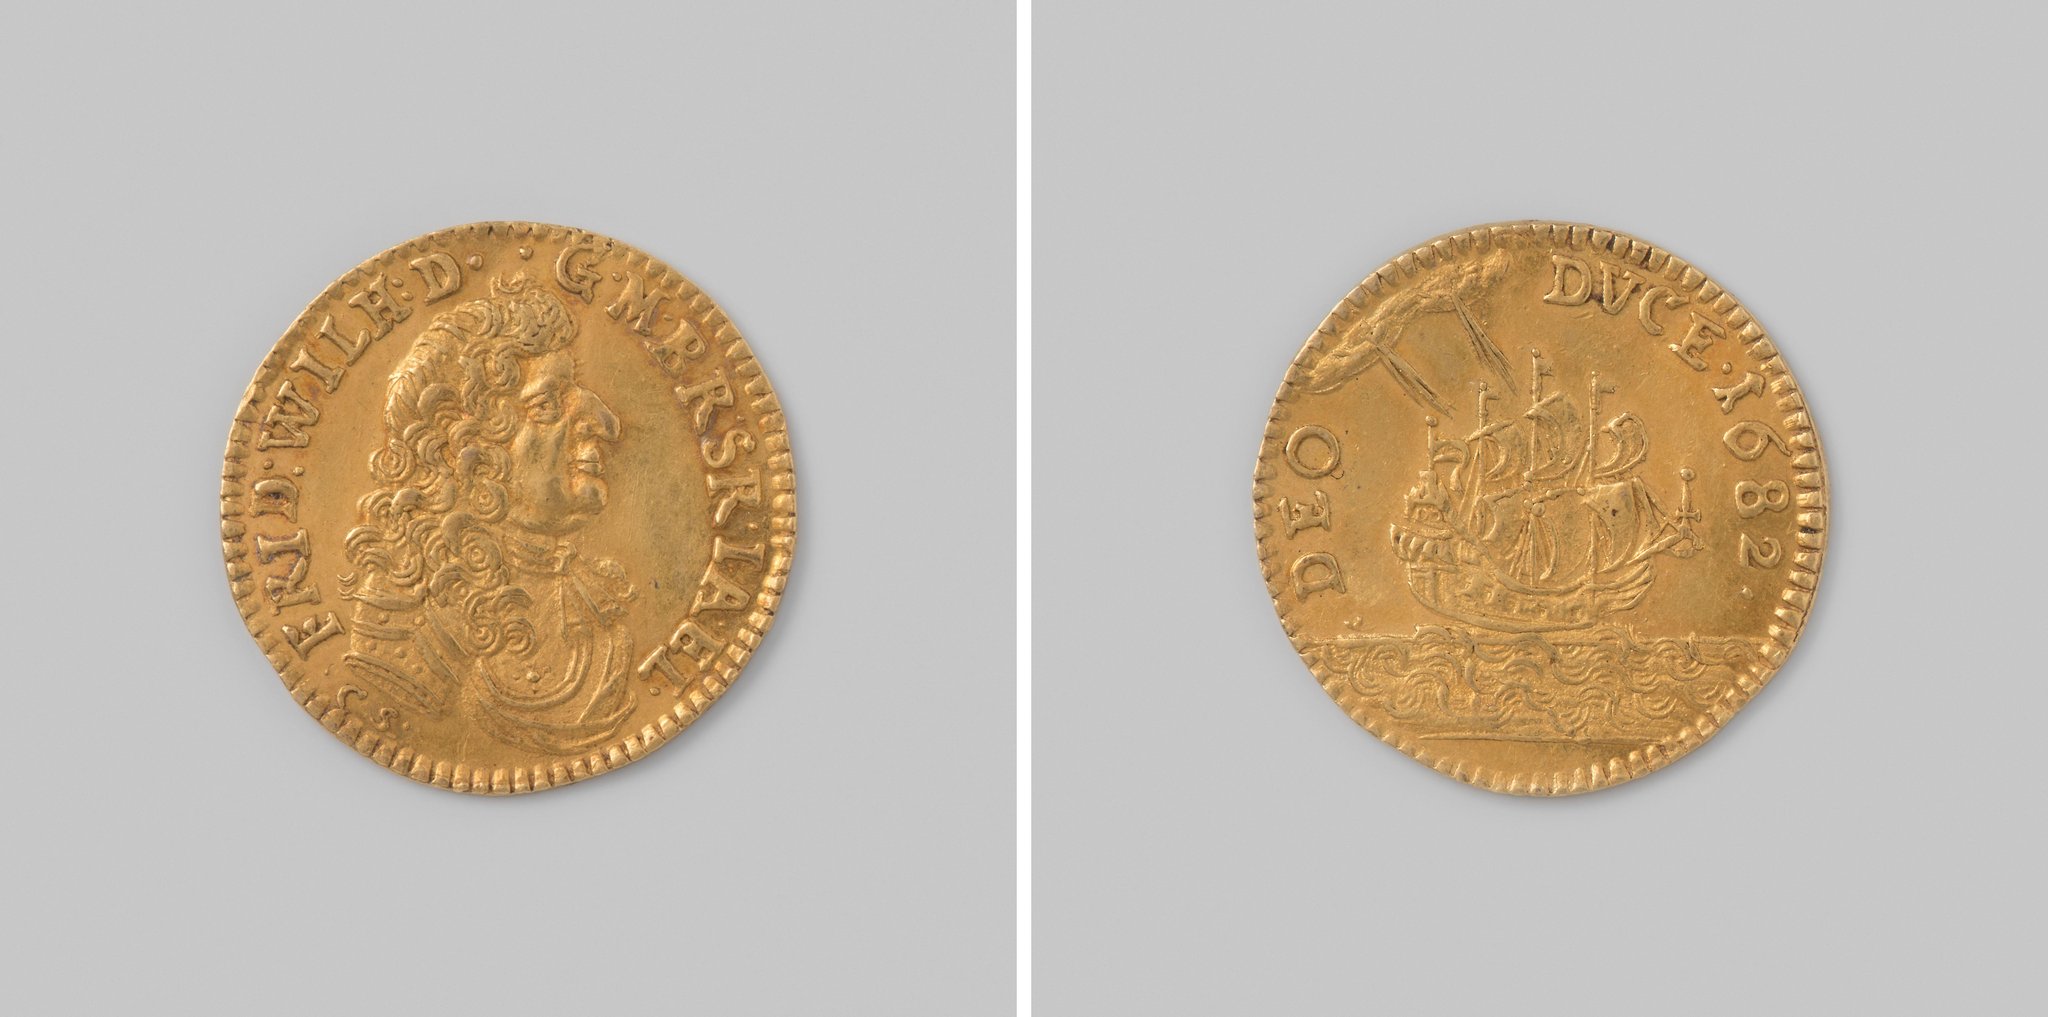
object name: gouden dukaat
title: Pruisen, markgraaf Friedrich Wilhelm van Brandenburg, dukaat van goud uit de Goudkust (Guinea), 1682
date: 1682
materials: gold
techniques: striking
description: Gouden munt. Voorzijde: borstbeeld van de markgraaf naar rechts. Onder het borstbeeld de letters C.S. Keerzijde: schip met volle zeilen op zee. Linksboven het schip twee wolken, waaruit wind wordt geblazen. Jaartal aan het eind van het omschrift.